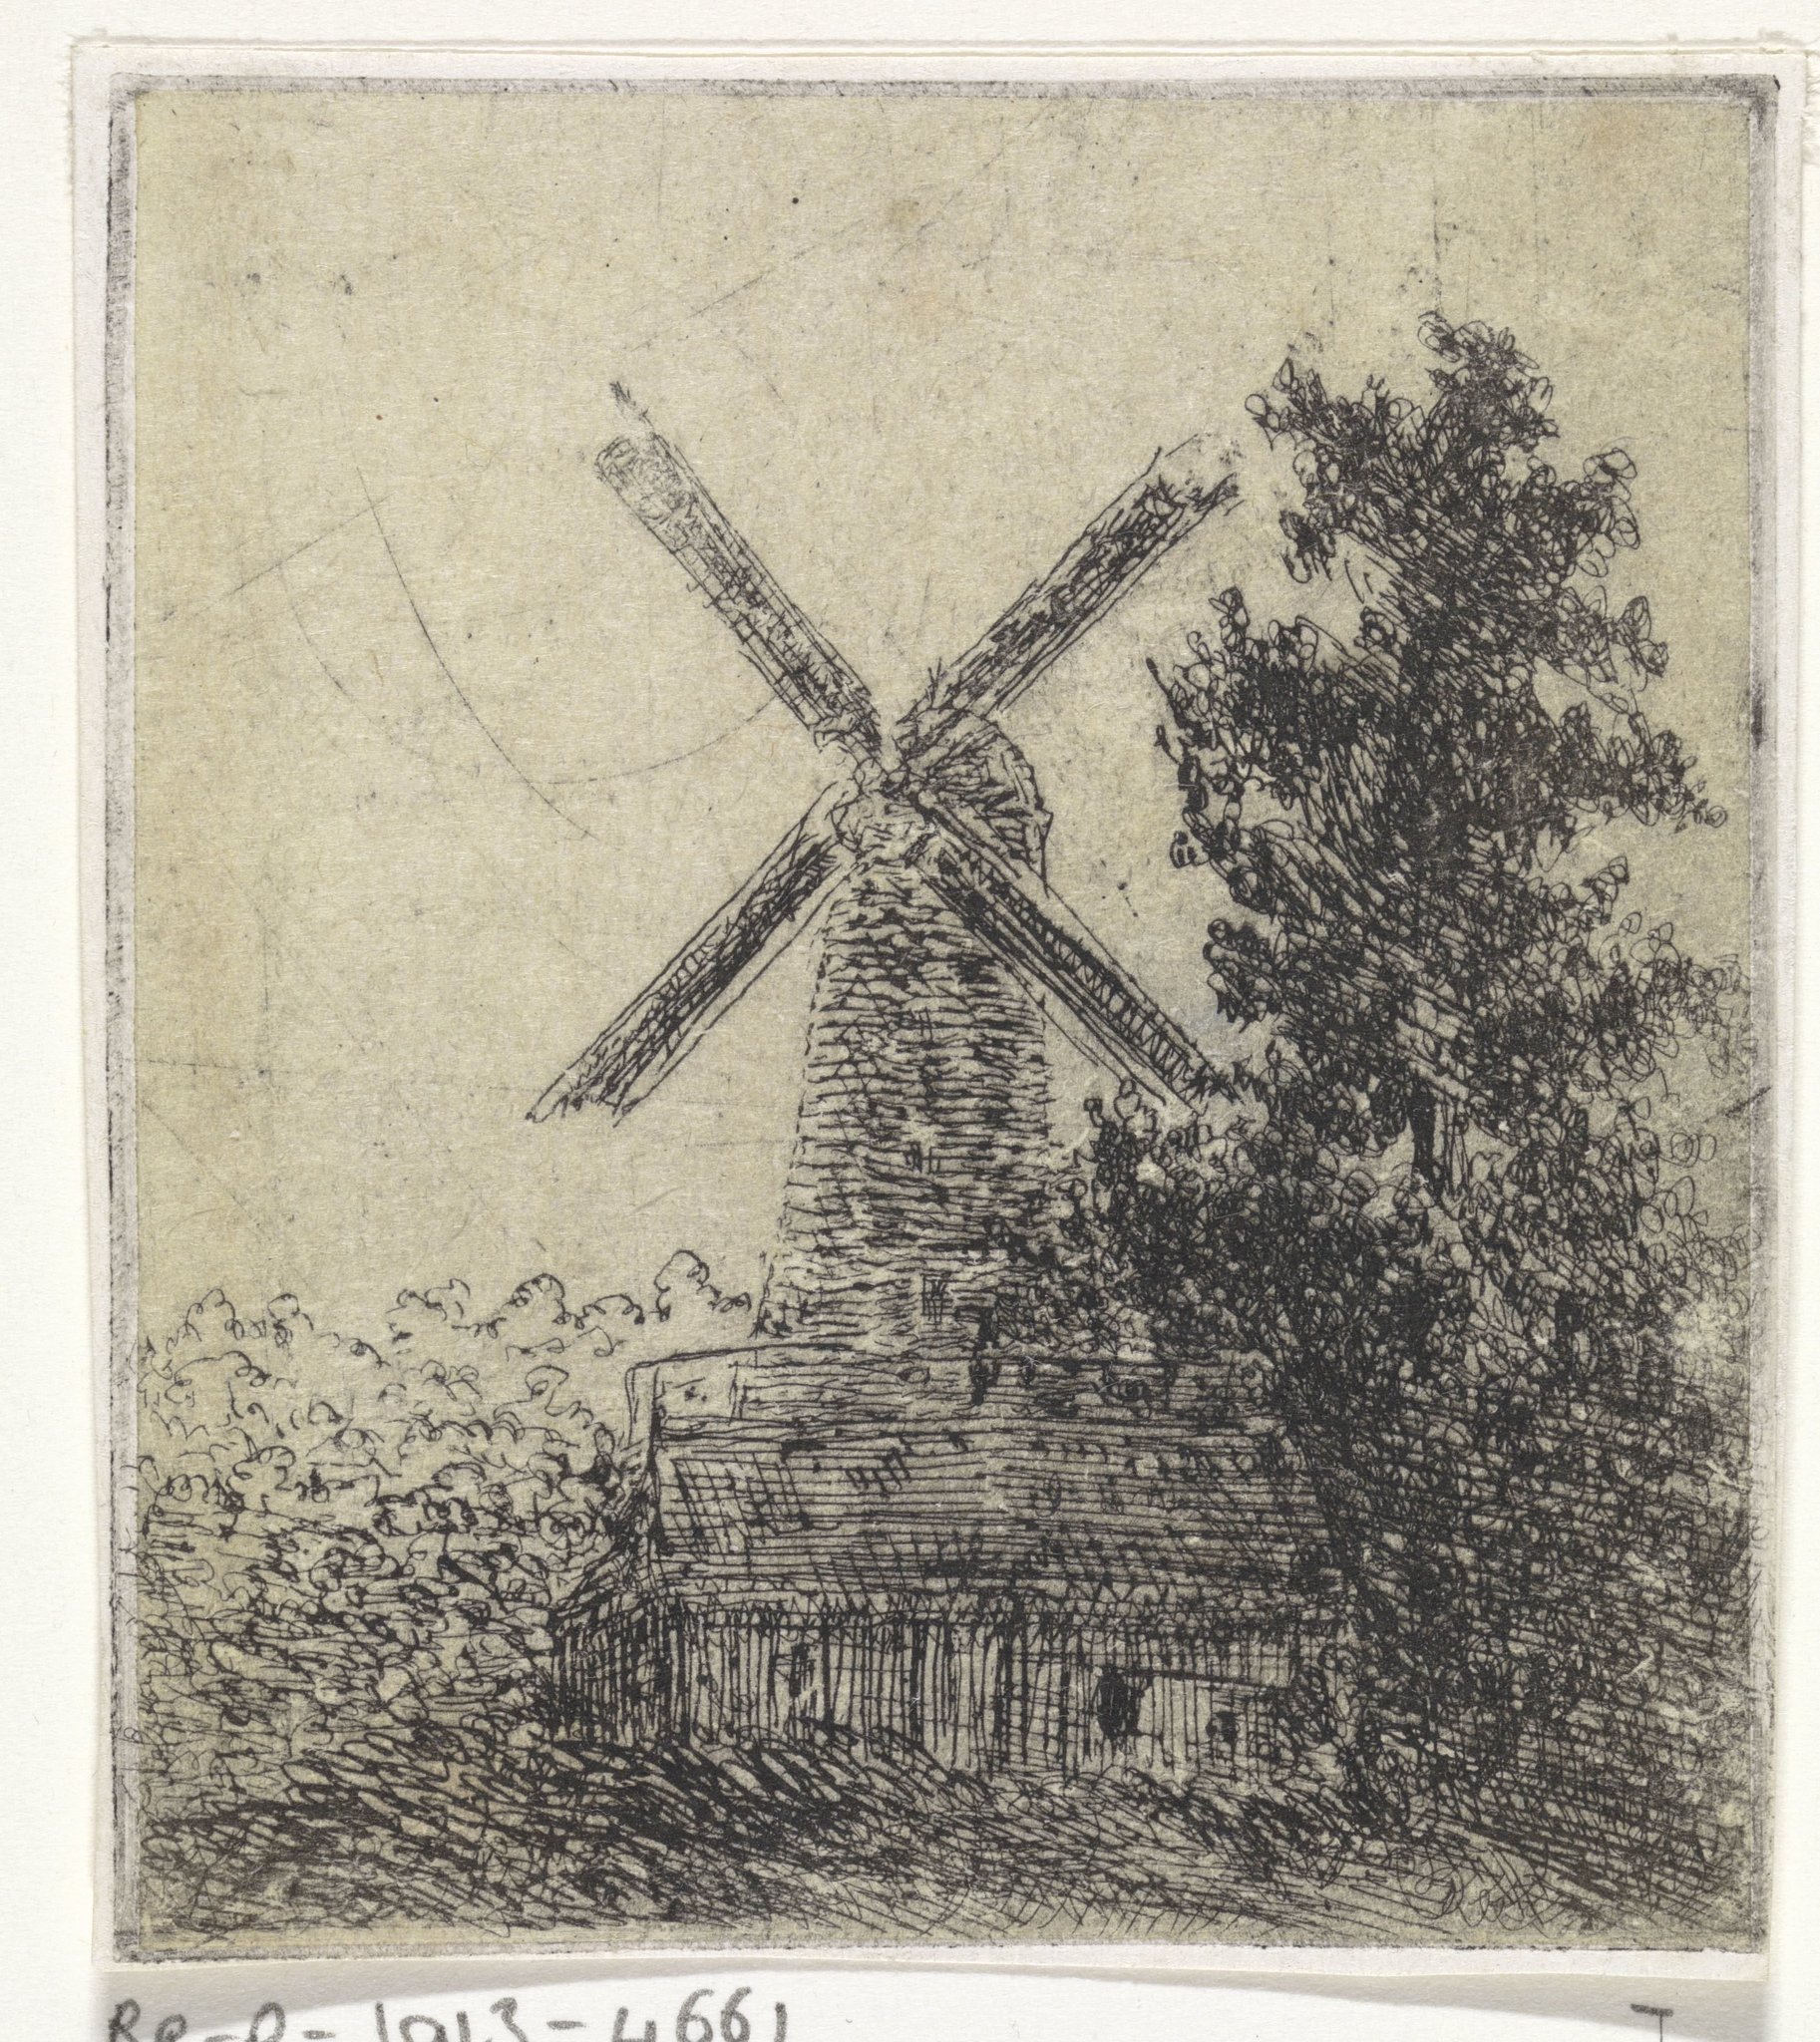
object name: print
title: Windmolen achter een hut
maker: arnoud schaepkens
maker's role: print maker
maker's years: 1816-1904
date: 1855-1904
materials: paper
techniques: drypoint, etching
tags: windmill in landscape, cottage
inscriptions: collector's mark: Lugt 2228